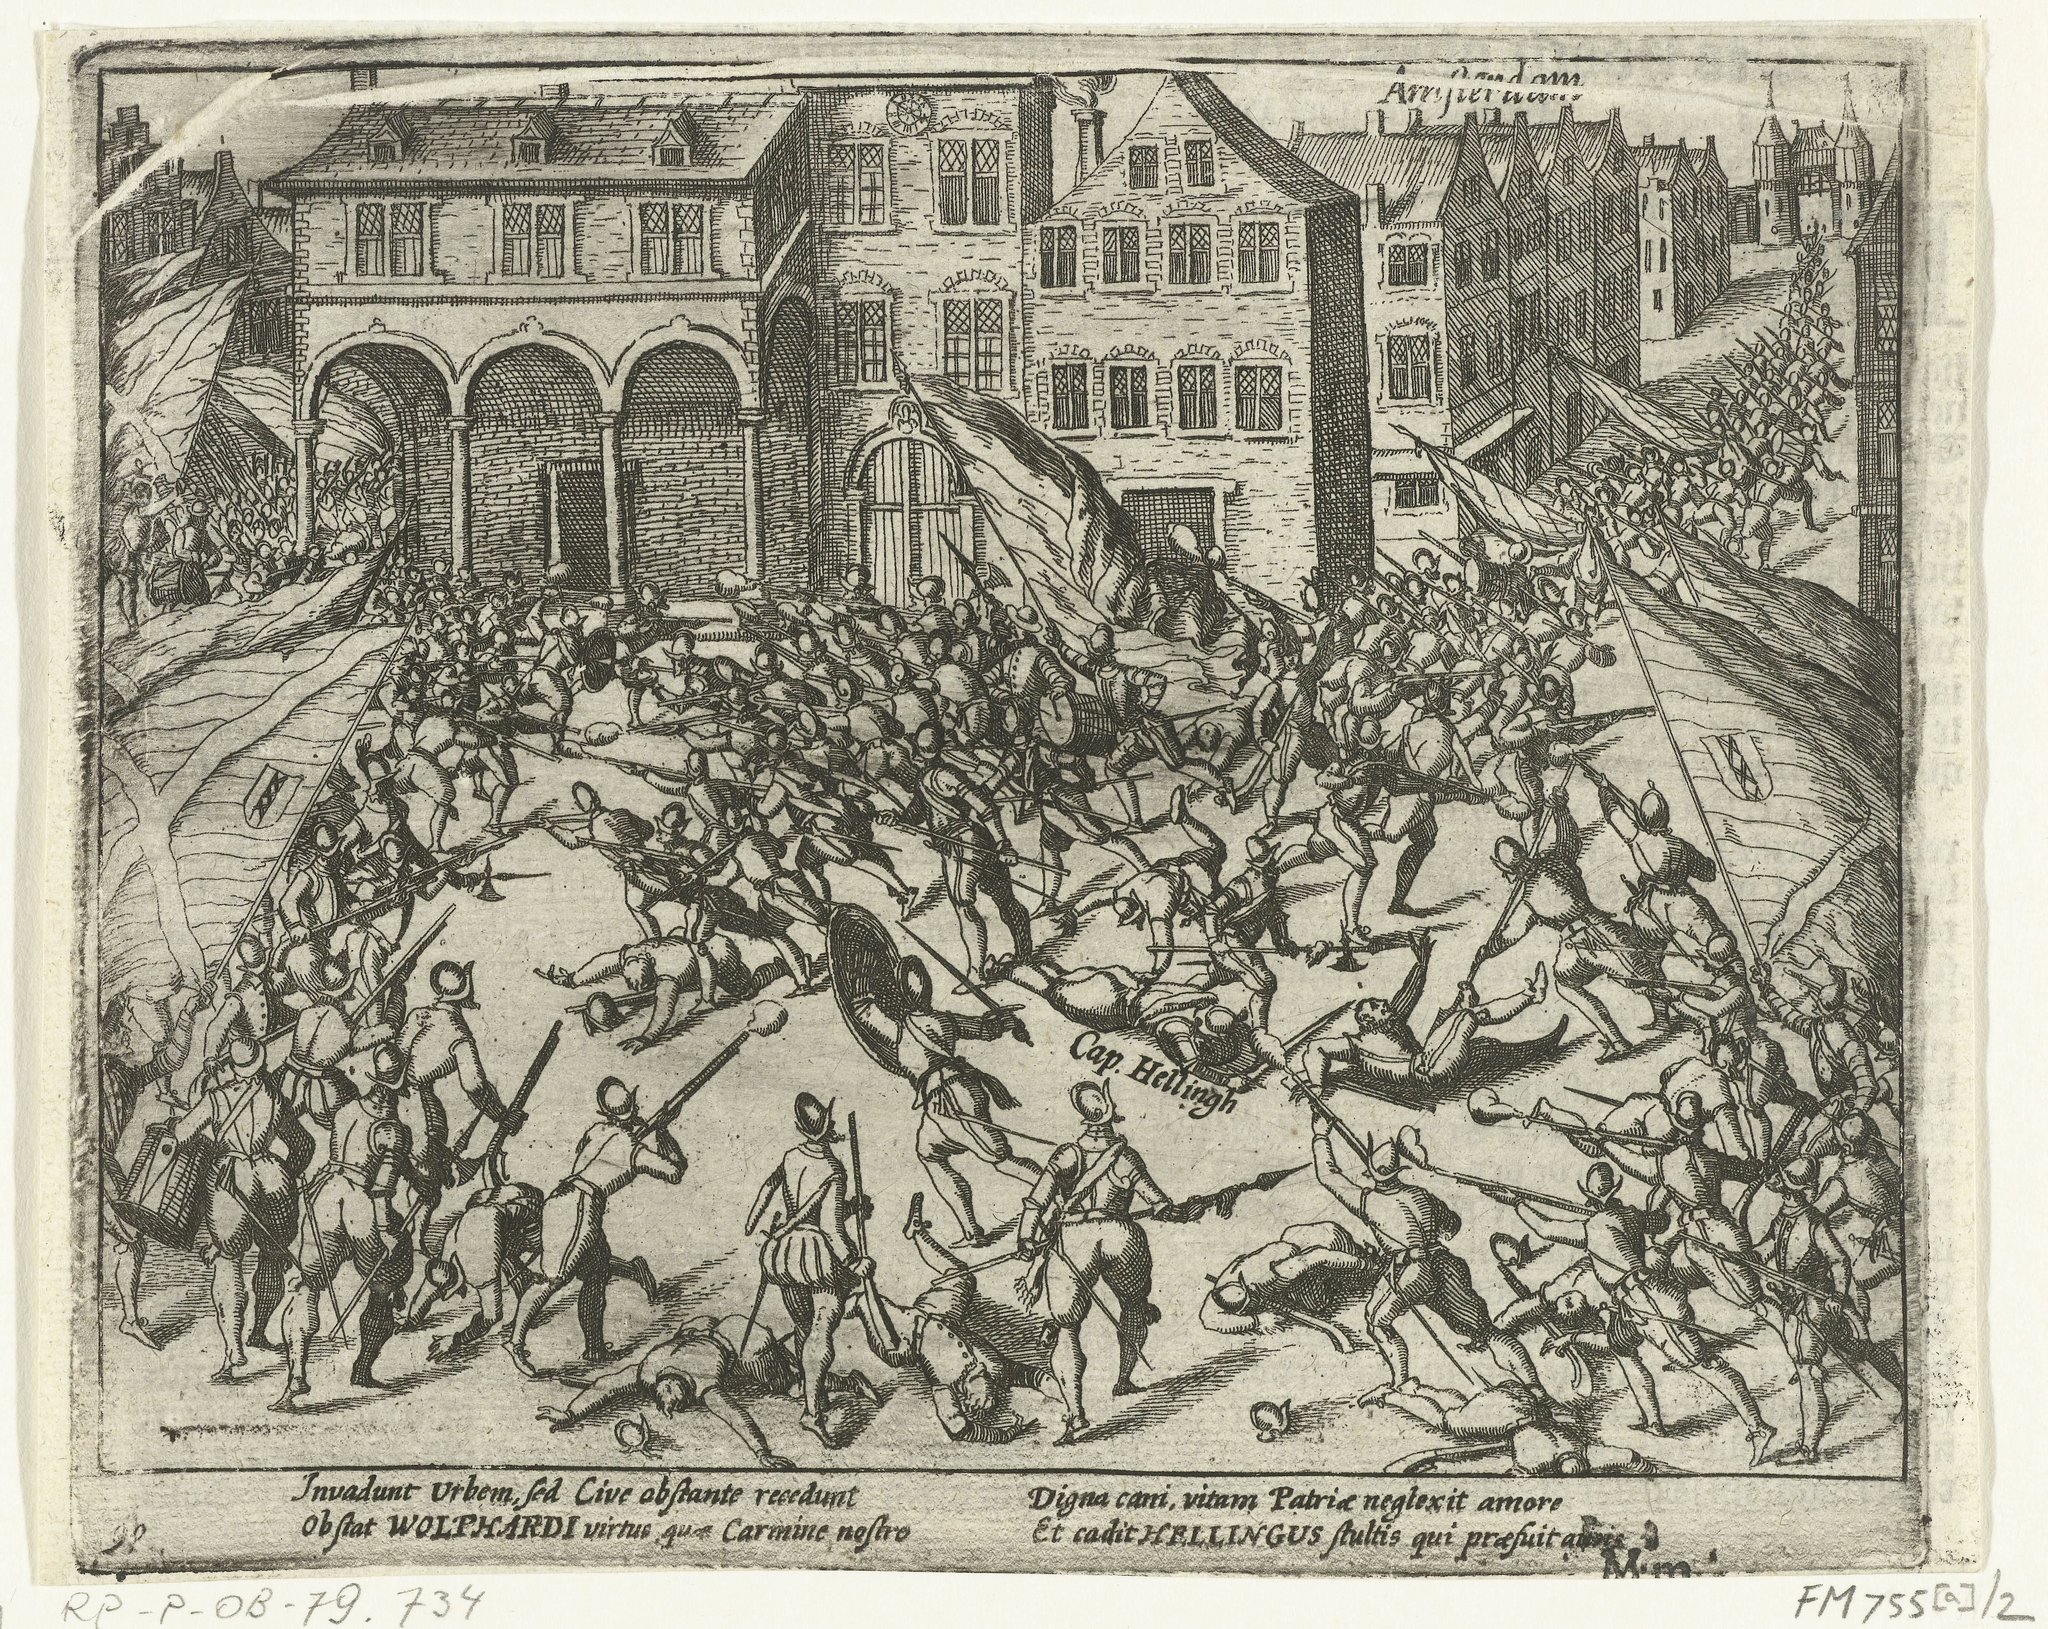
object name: print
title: Staatse troep verslagen op de Dam, 1577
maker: Anonymous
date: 1613-1615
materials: paper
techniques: etching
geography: northern netherlands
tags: haarlem, battle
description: De Staatse troepen onder bevel van Helling en Ruychaver worden bij felle gevechten op de Dam door de Amsterdammers verslagen. Helling zelf komt hierbij om het leven, 23 november 1577. Met onderschrift van 4 regels in het Latijn. Genummerd: 90. Bedrukt op achterzijde met tekst in het Nederlands.